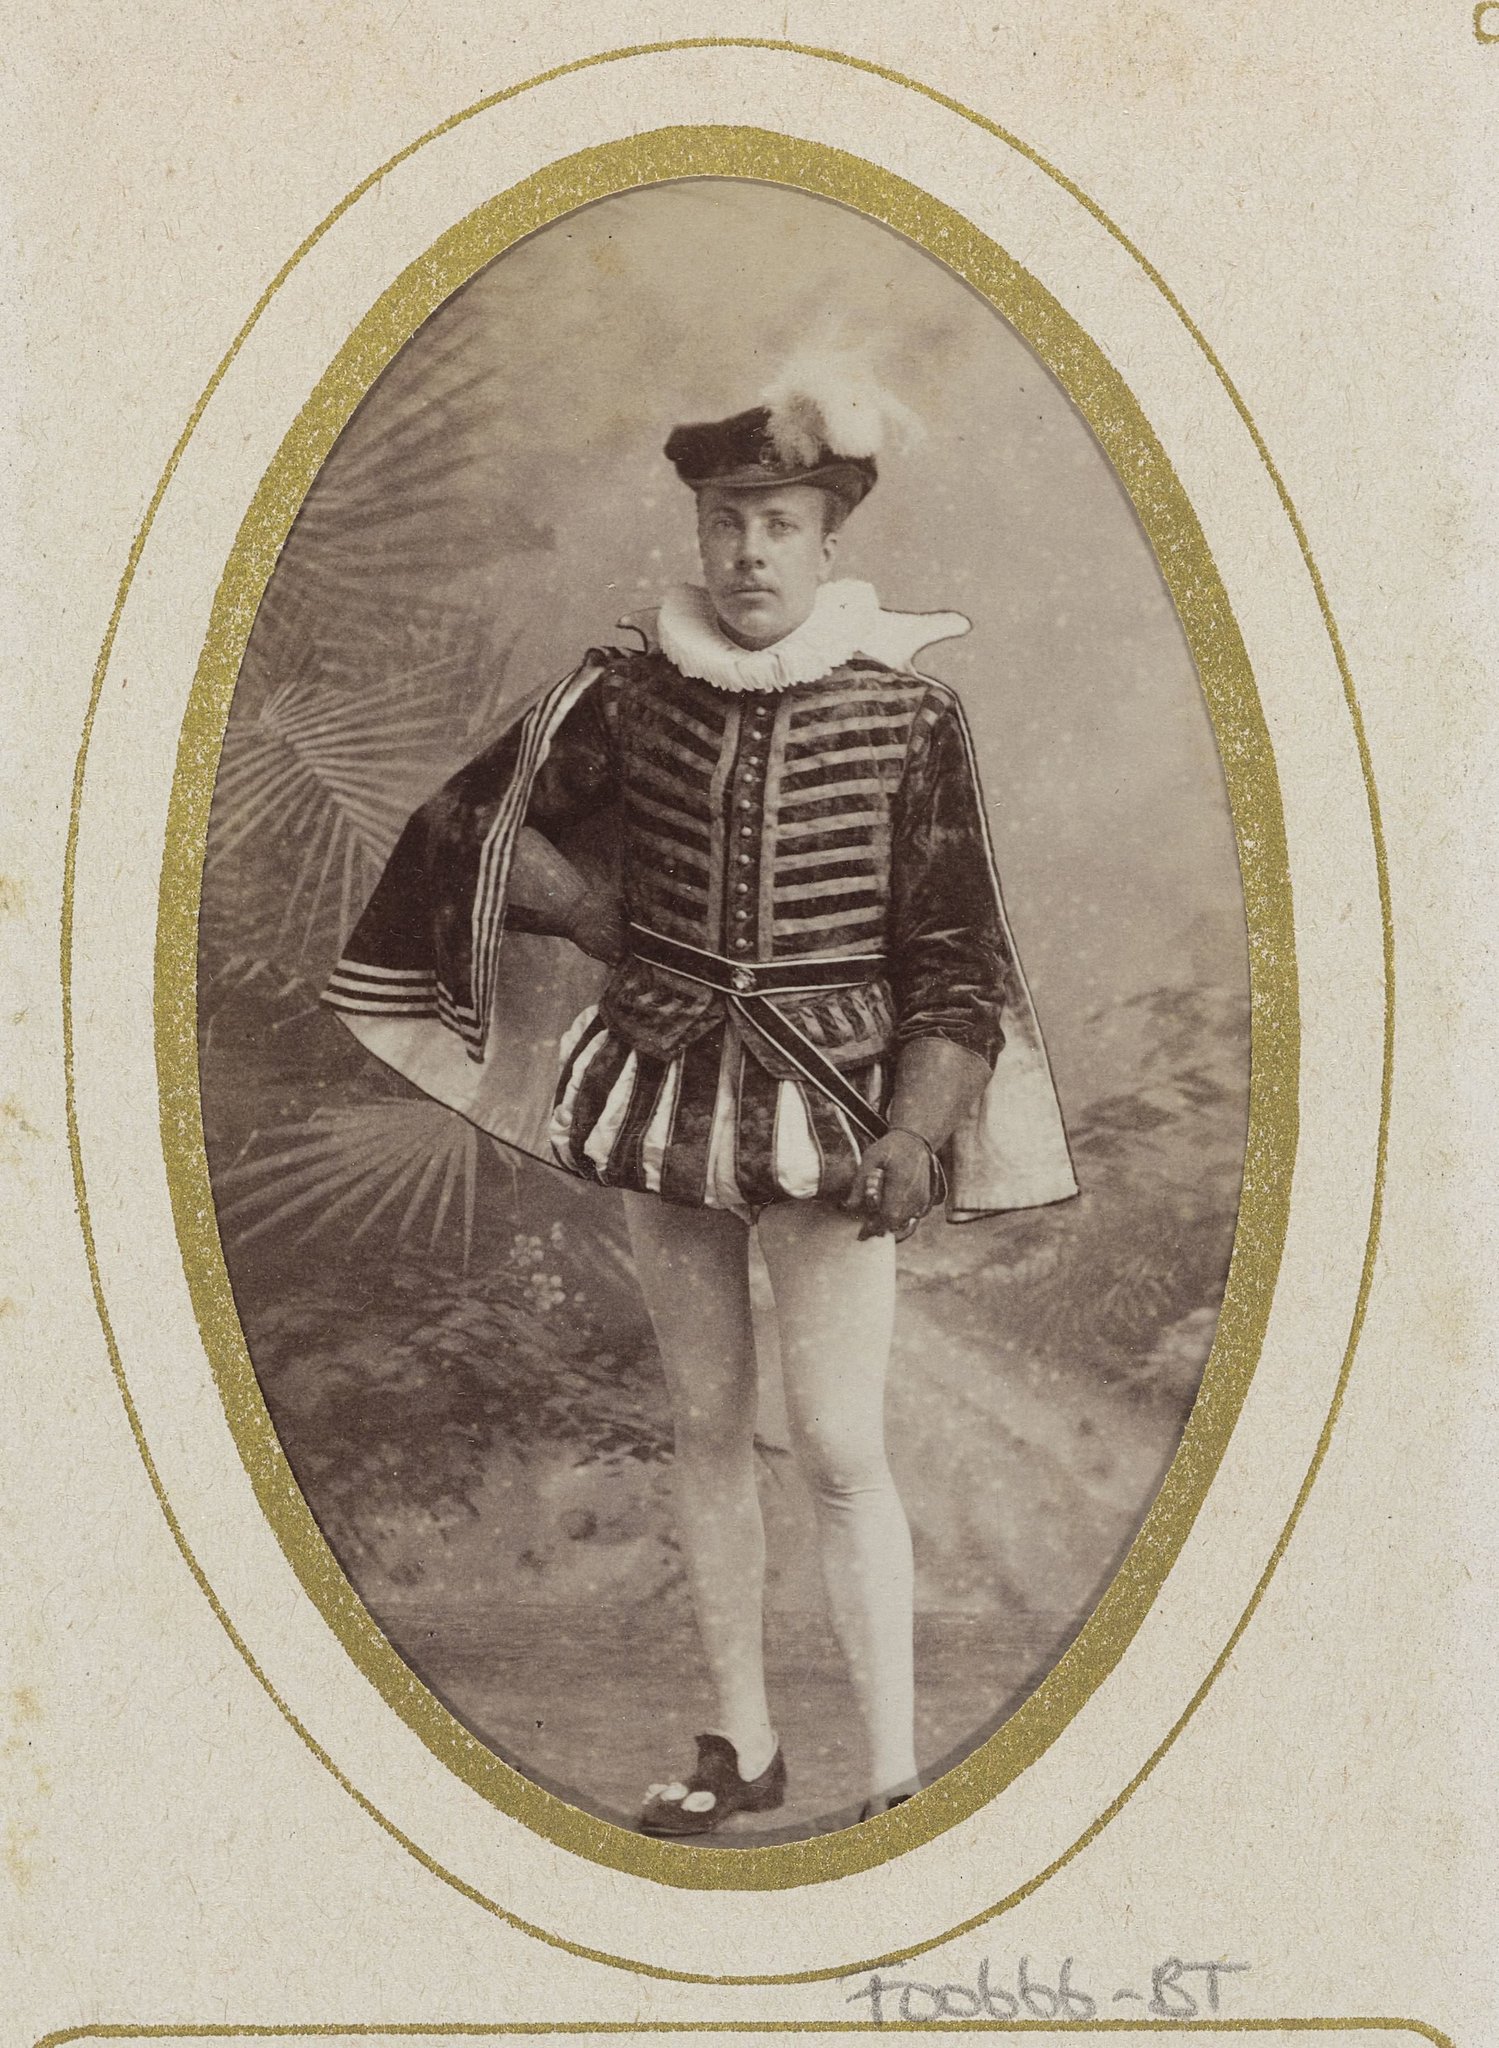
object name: photograph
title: Portret van Johannes Pieter Stephan Gualthérie van Weezel in kostuum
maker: antonius joannes van der stok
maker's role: fotograaf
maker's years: 1862-1941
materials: cardboard, photographic support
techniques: albumen print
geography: leiden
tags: historical persons, historical costume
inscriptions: inscription: ‘Ant. J. van der Stok/ Leiden Rapenburg 13.’, name: ‘J. P. S. Gualtherie v. Weezel./ 106.’